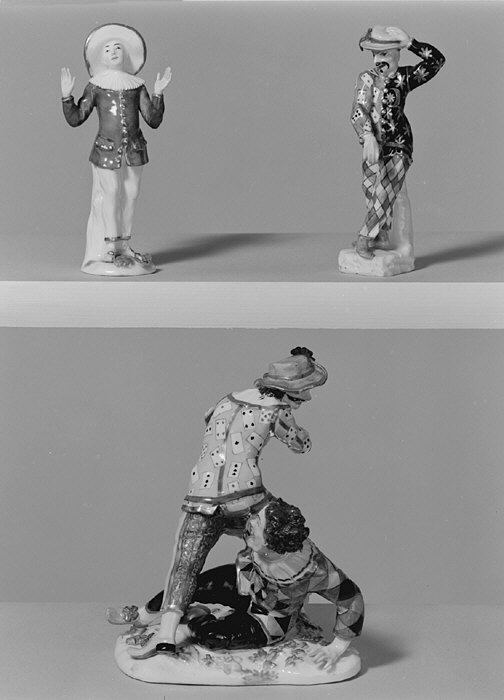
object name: figure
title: Harlequin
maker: meissen manufactory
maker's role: manufactory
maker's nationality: german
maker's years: 1710-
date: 1730-1732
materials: hard paste porcelain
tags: men,women